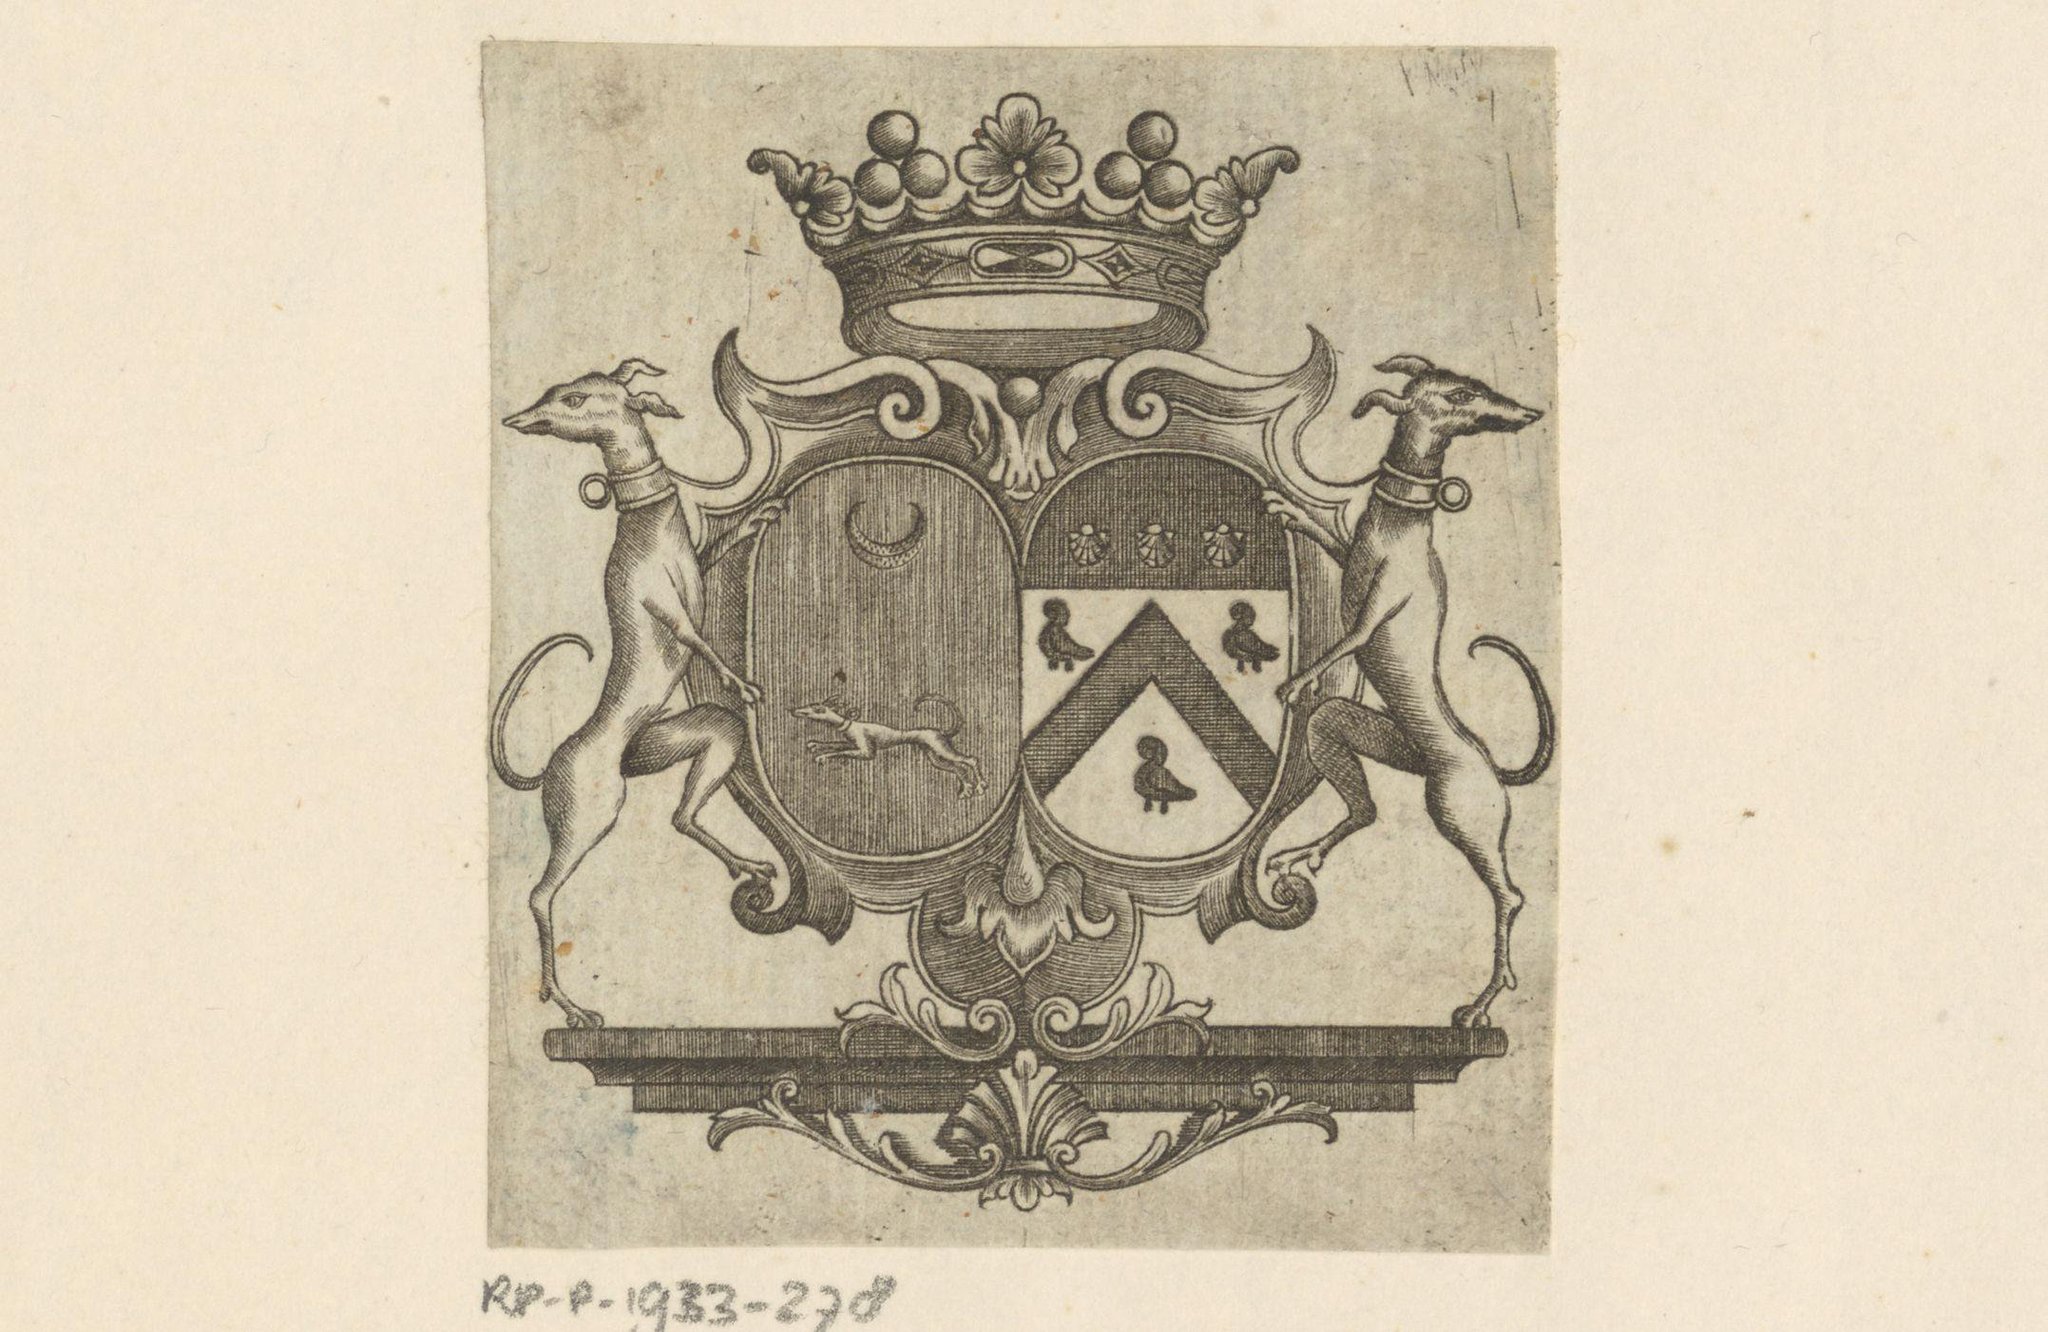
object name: bookplate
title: Ex libris van onbekend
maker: Anonymous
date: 1700-1850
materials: paper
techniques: etching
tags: armorial bearing, heraldry, dog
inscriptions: collector's mark: Lugt 2760